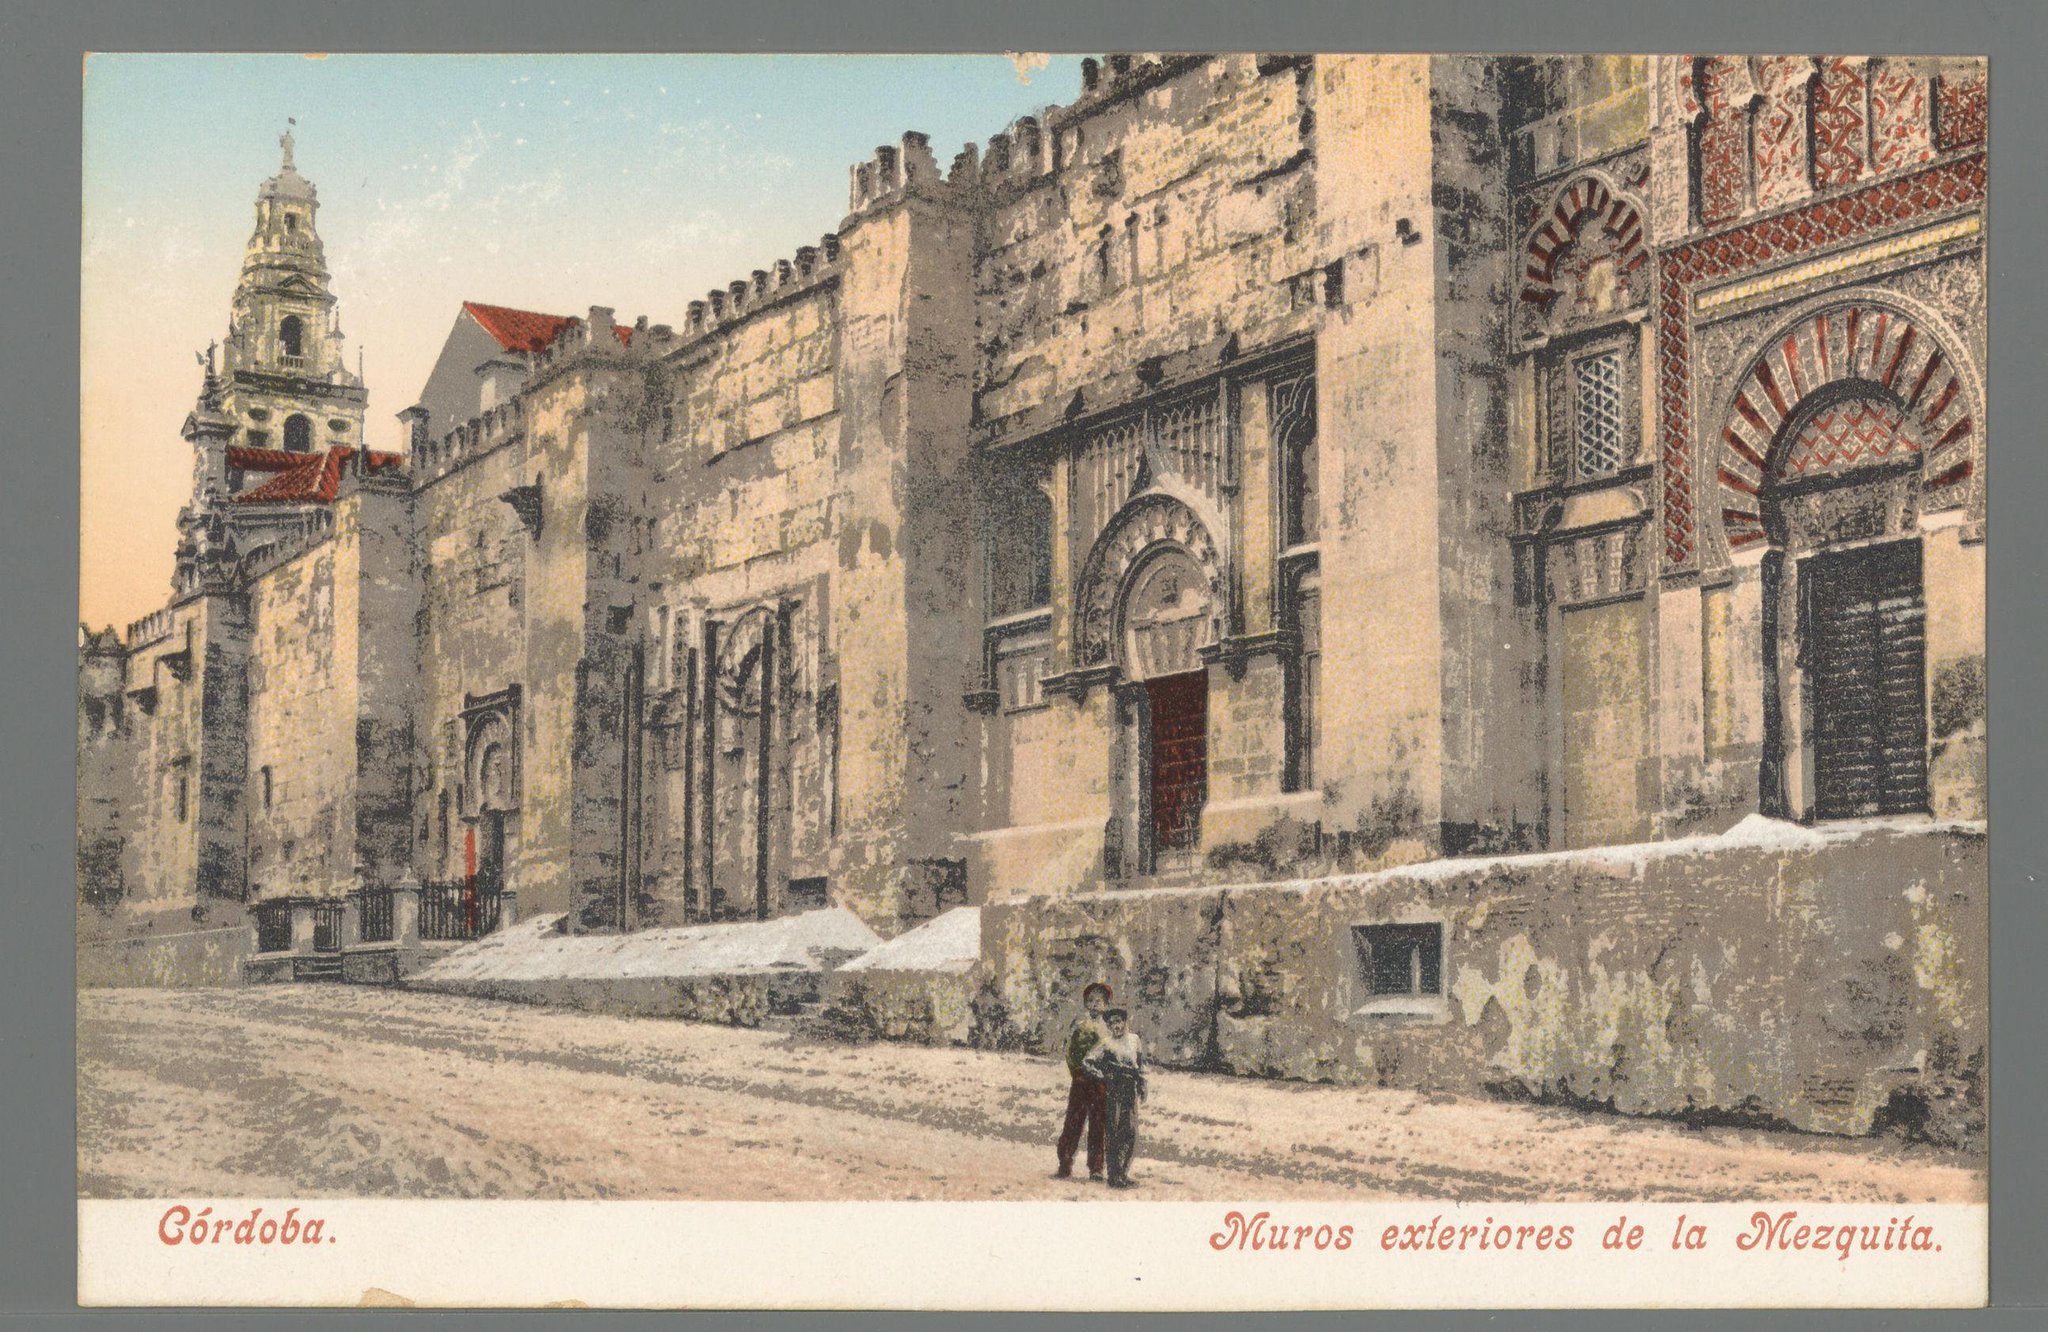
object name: photomechanical print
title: Córdoba. Muros exteriores de la Mezquita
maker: Anonymous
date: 1890-1906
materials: cardboard, photographic process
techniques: writing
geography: córdoba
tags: church (exterior)